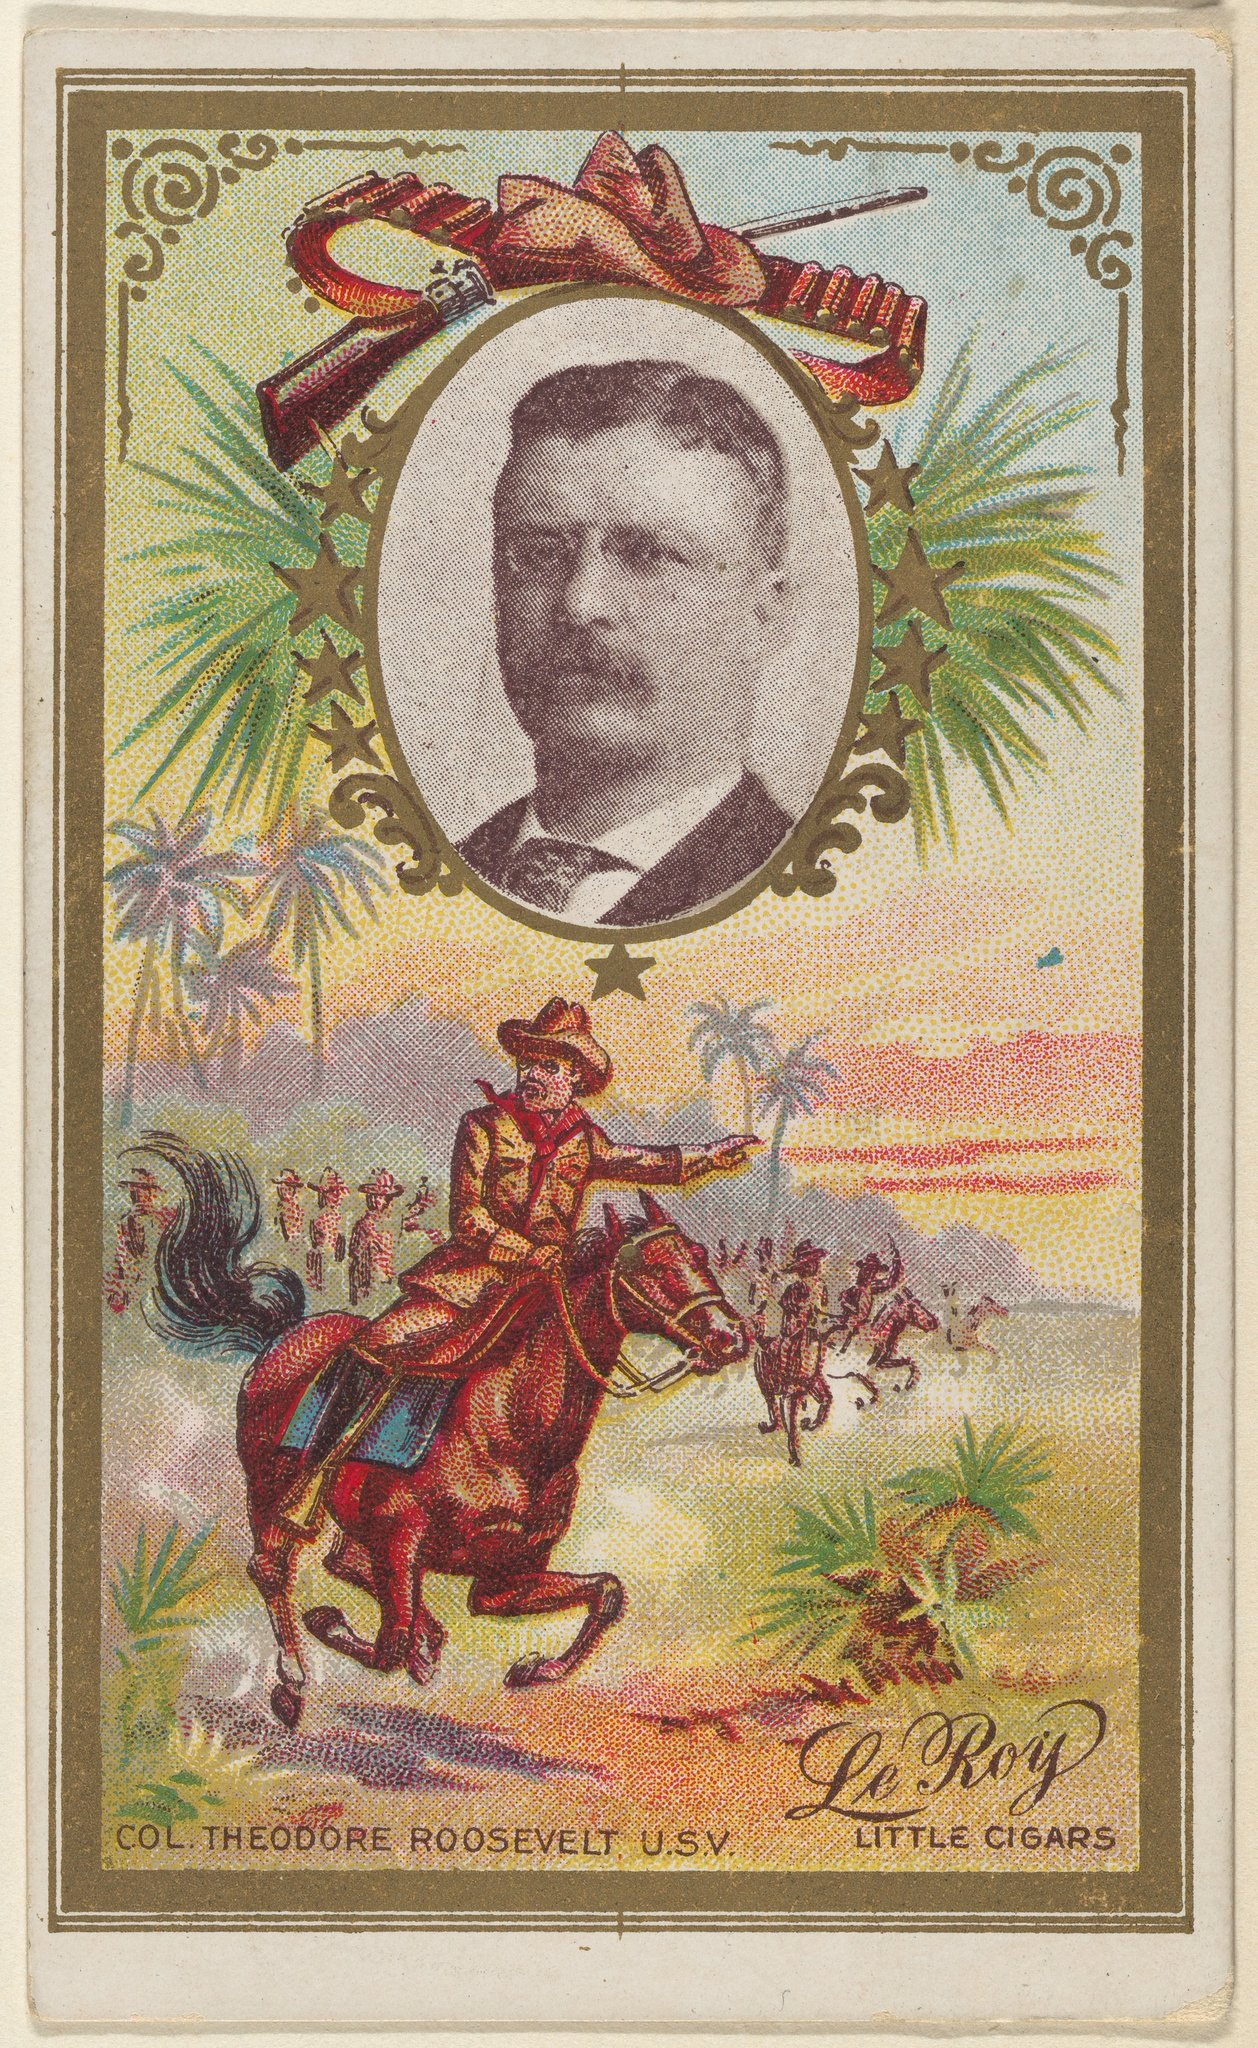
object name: print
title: Colonel Theodore Roosevelt, U.S. Volunteers, from the "Generals" series (T63), issued by LeRoy Little Cigars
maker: leroy little cigars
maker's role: publisher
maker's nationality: american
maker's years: 1850-1950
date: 1898-1901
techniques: color lithograph